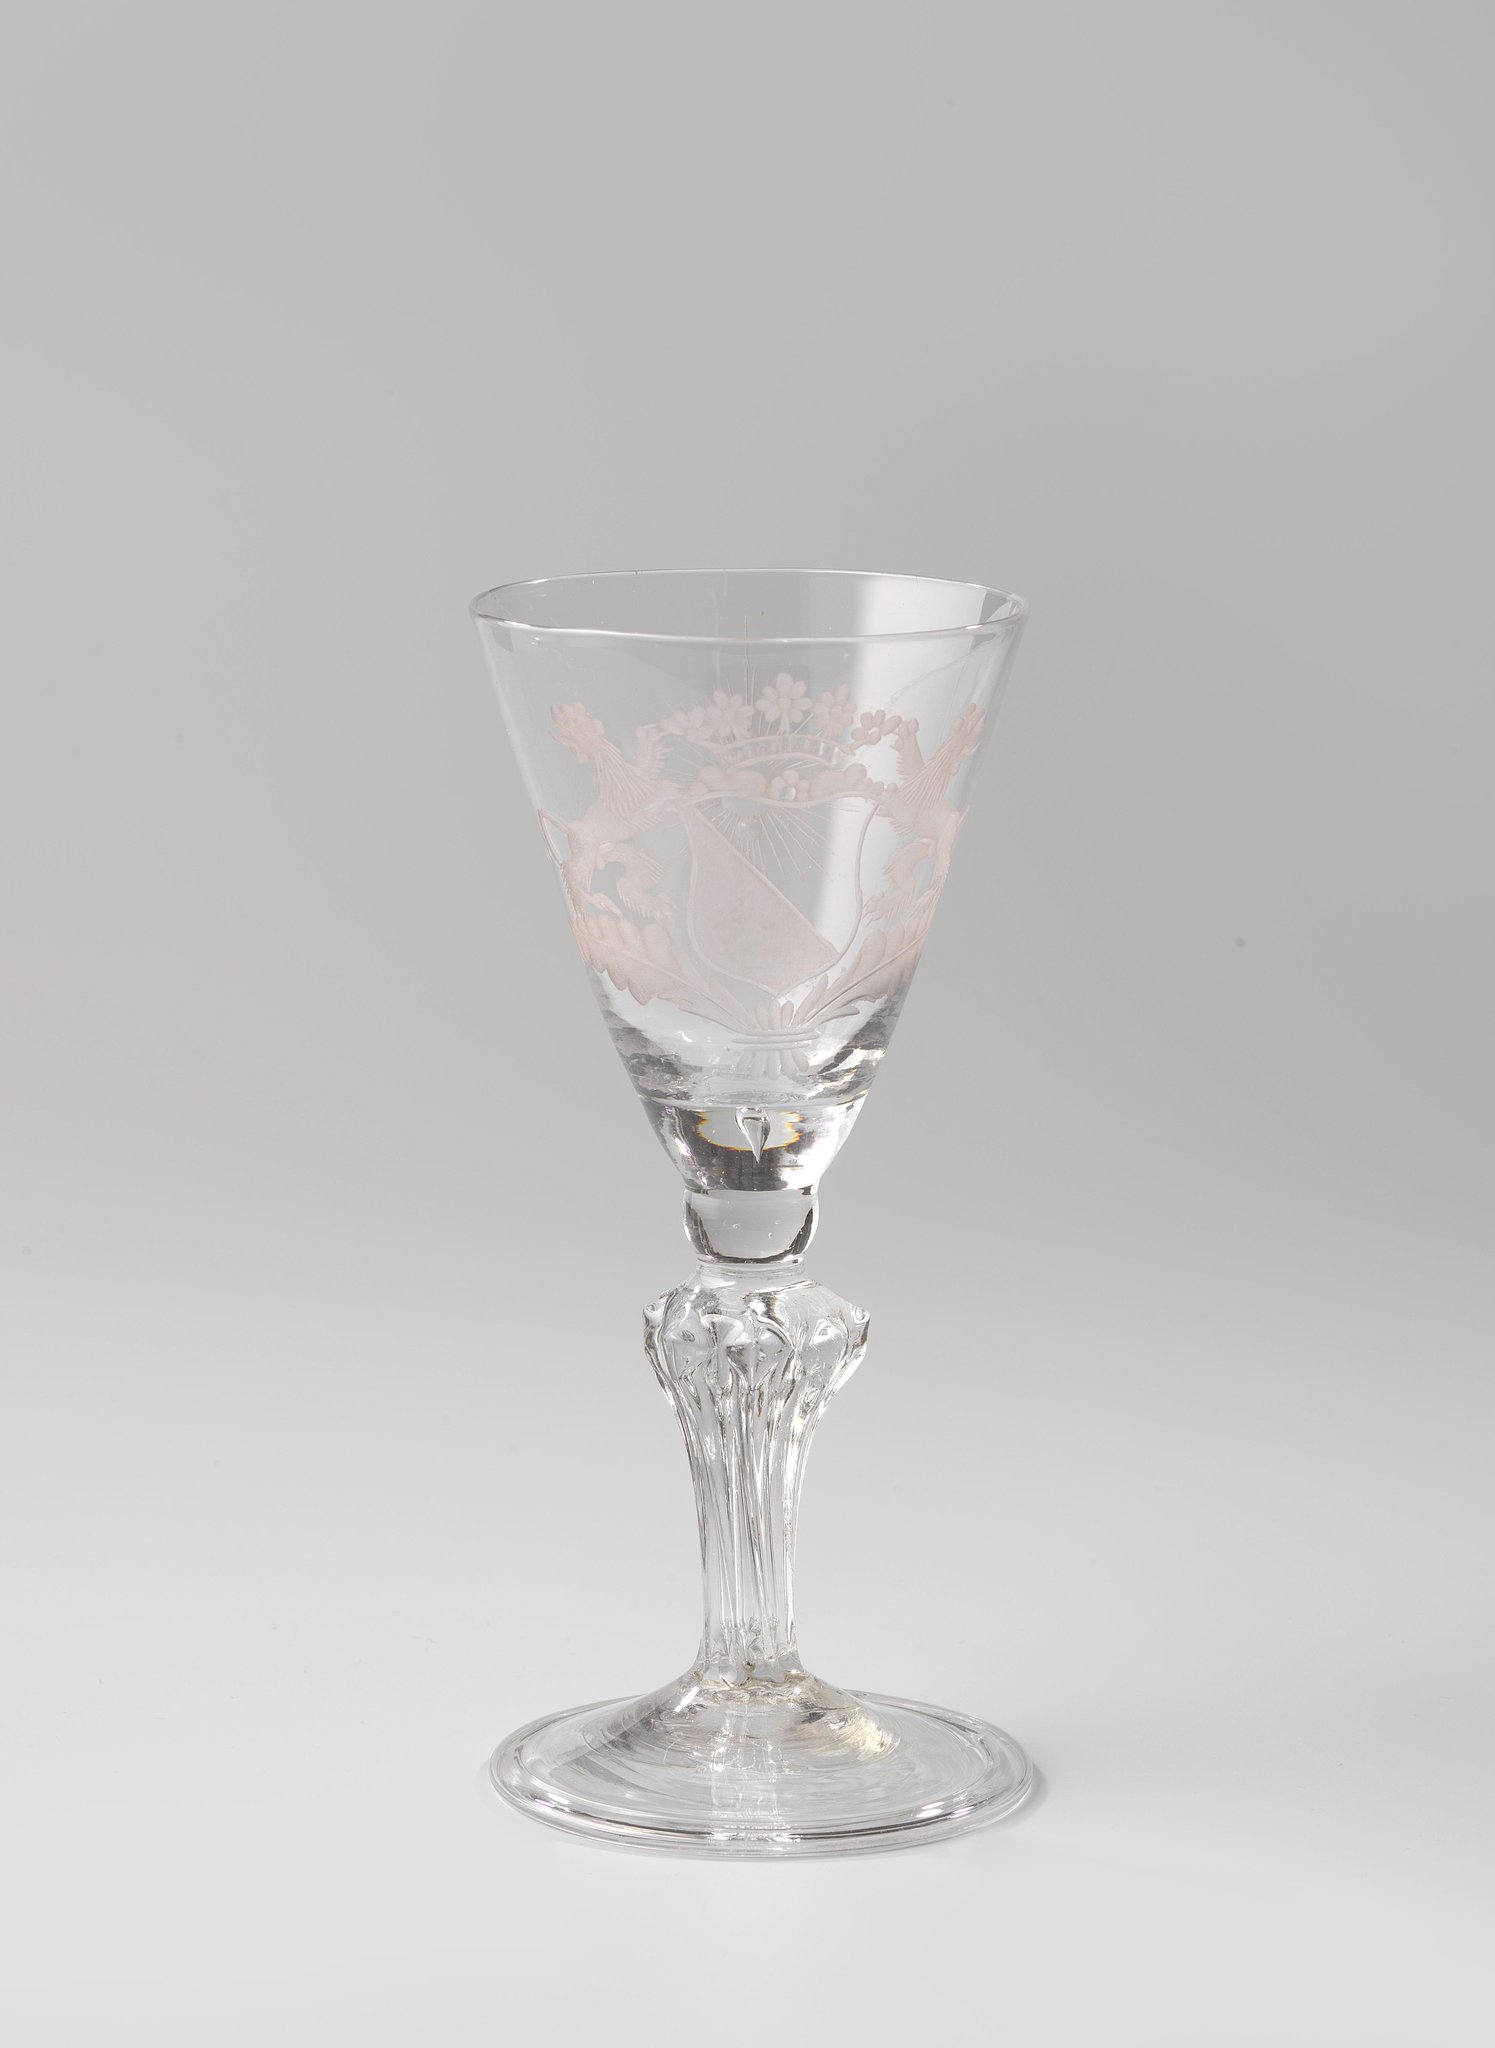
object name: goblet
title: Kelkglas met het wapen van de stad Utrecht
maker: Anonymous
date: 1725-1750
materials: glass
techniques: glassblowing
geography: northern netherlands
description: Kelkglas van helder, kleurloos glas, met het gekroonde wapen van de stad Utrecht.